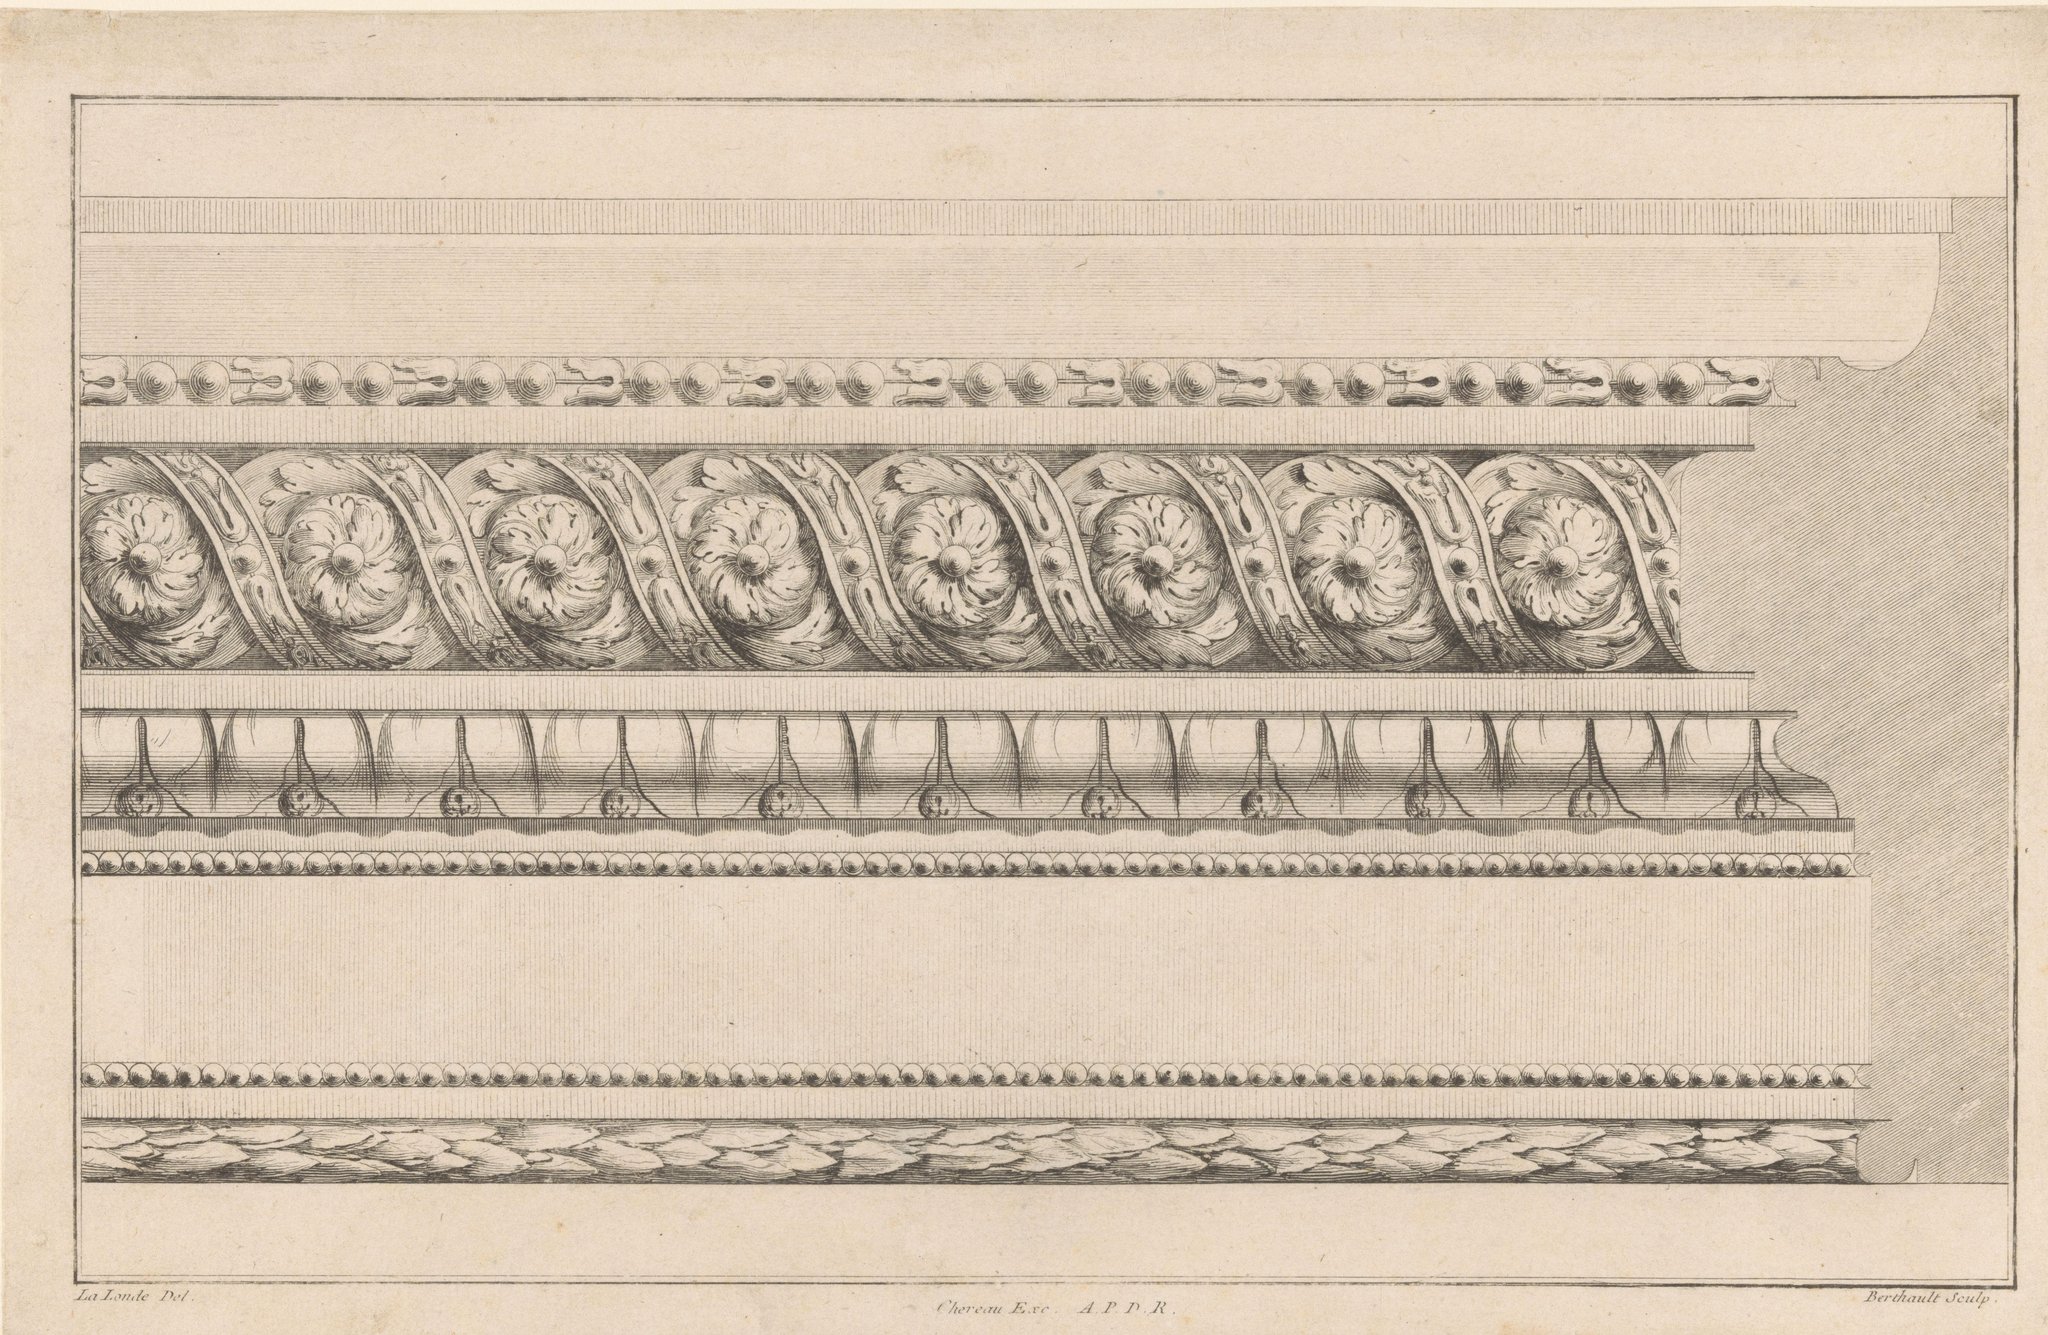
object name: print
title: Lijst met bloemmotieven en tulpen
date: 1784-1785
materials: paper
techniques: engraving, etching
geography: paris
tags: ornaments ~ art (+ framing decorations)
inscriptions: collector's mark: Lugt 2760, collector's mark: Lugt 2228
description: Een geornamenteerde lijst met bloemmotieven en tulpen.